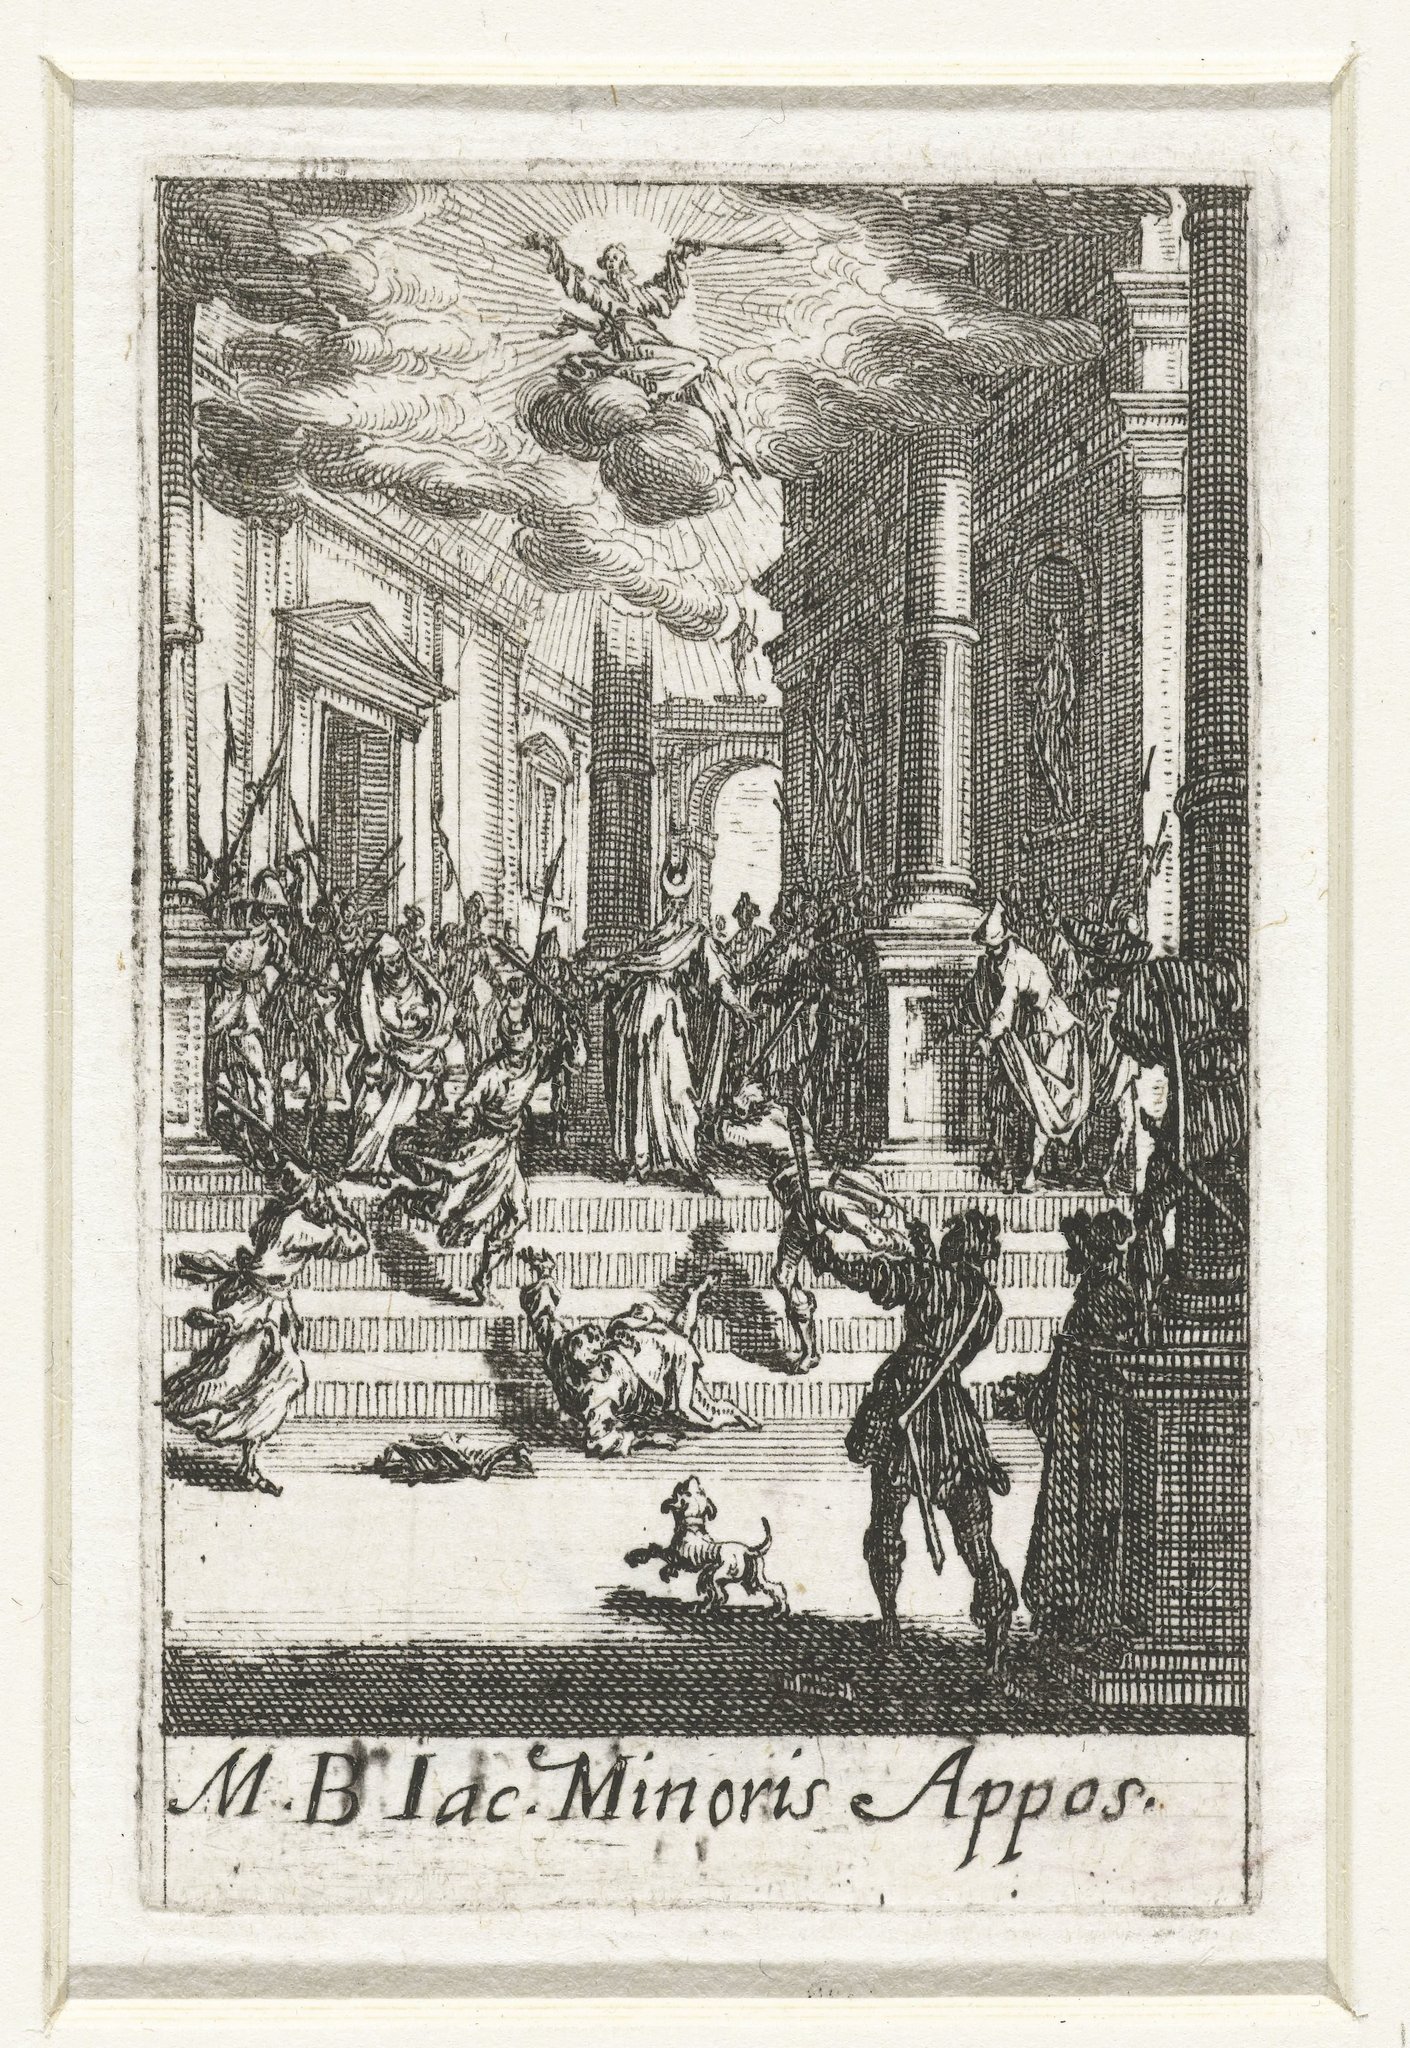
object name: print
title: M. B Iac. Minoris Appos.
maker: jacques callot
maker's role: draughtsman, print maker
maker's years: 1592-1635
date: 1632-1634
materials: paper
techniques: etching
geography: nancy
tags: james is stoned, or beaten to death (with a fuller's club), the apostle james the less, first bishop of jerusalem; possible attributes: book, fuller's club, scroll - martyrdom, suffering, misfortune, death of male saint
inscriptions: collector's mark: Lugt 240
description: Jakobus de Mindere wordt door mannen met knuppels doodgeslagen. Boven deze scène is Jakobus de Mindere nogmaals afgebeeld, op een wolk in de hemel, een knuppel in de hand. Onder de voorstelling een onderschrift in Latijn. Deze prent is onderdeel van een reeks van 16 prenten, bestaande uit een titelblad en 15 voorstellingen van de martelingen die de apostelen hebben ondergaan.